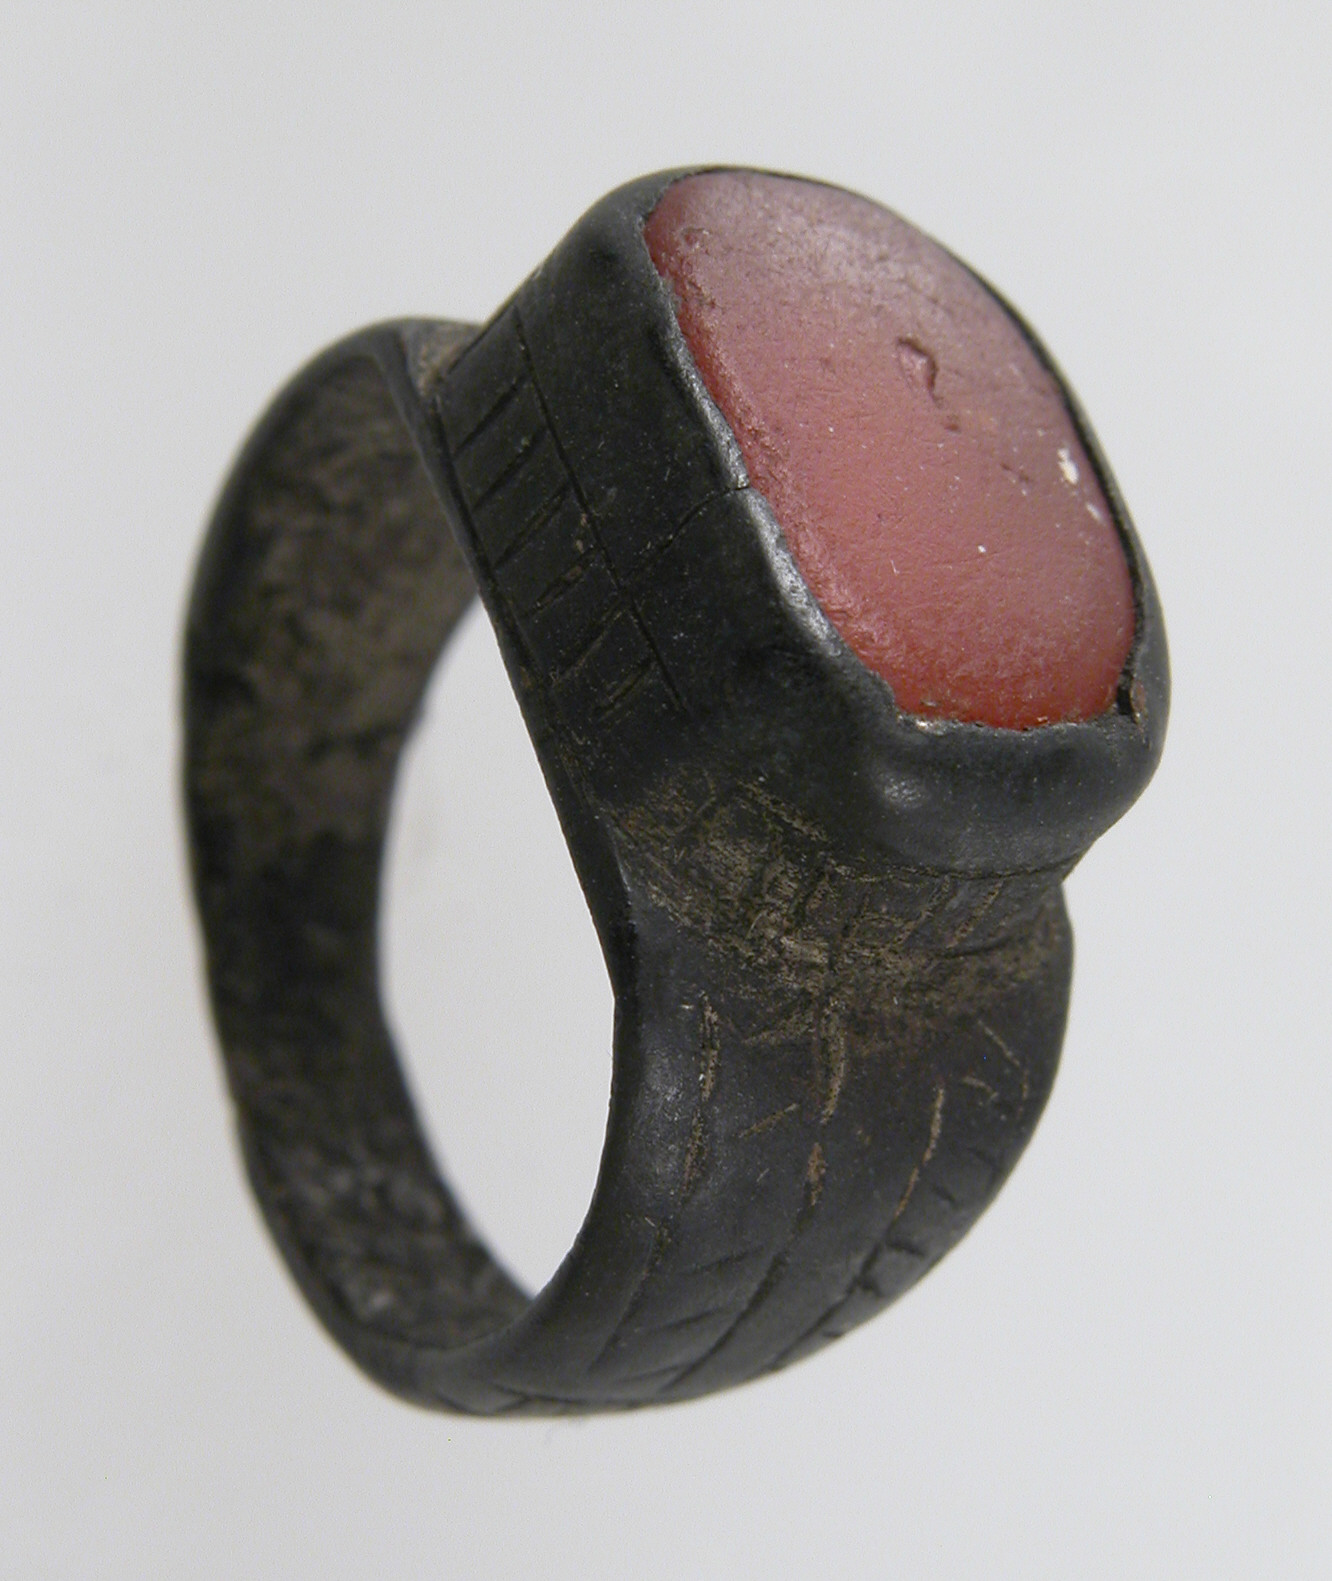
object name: ring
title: Finger Ring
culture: frankish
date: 1-400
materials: gemstone, silver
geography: northern france